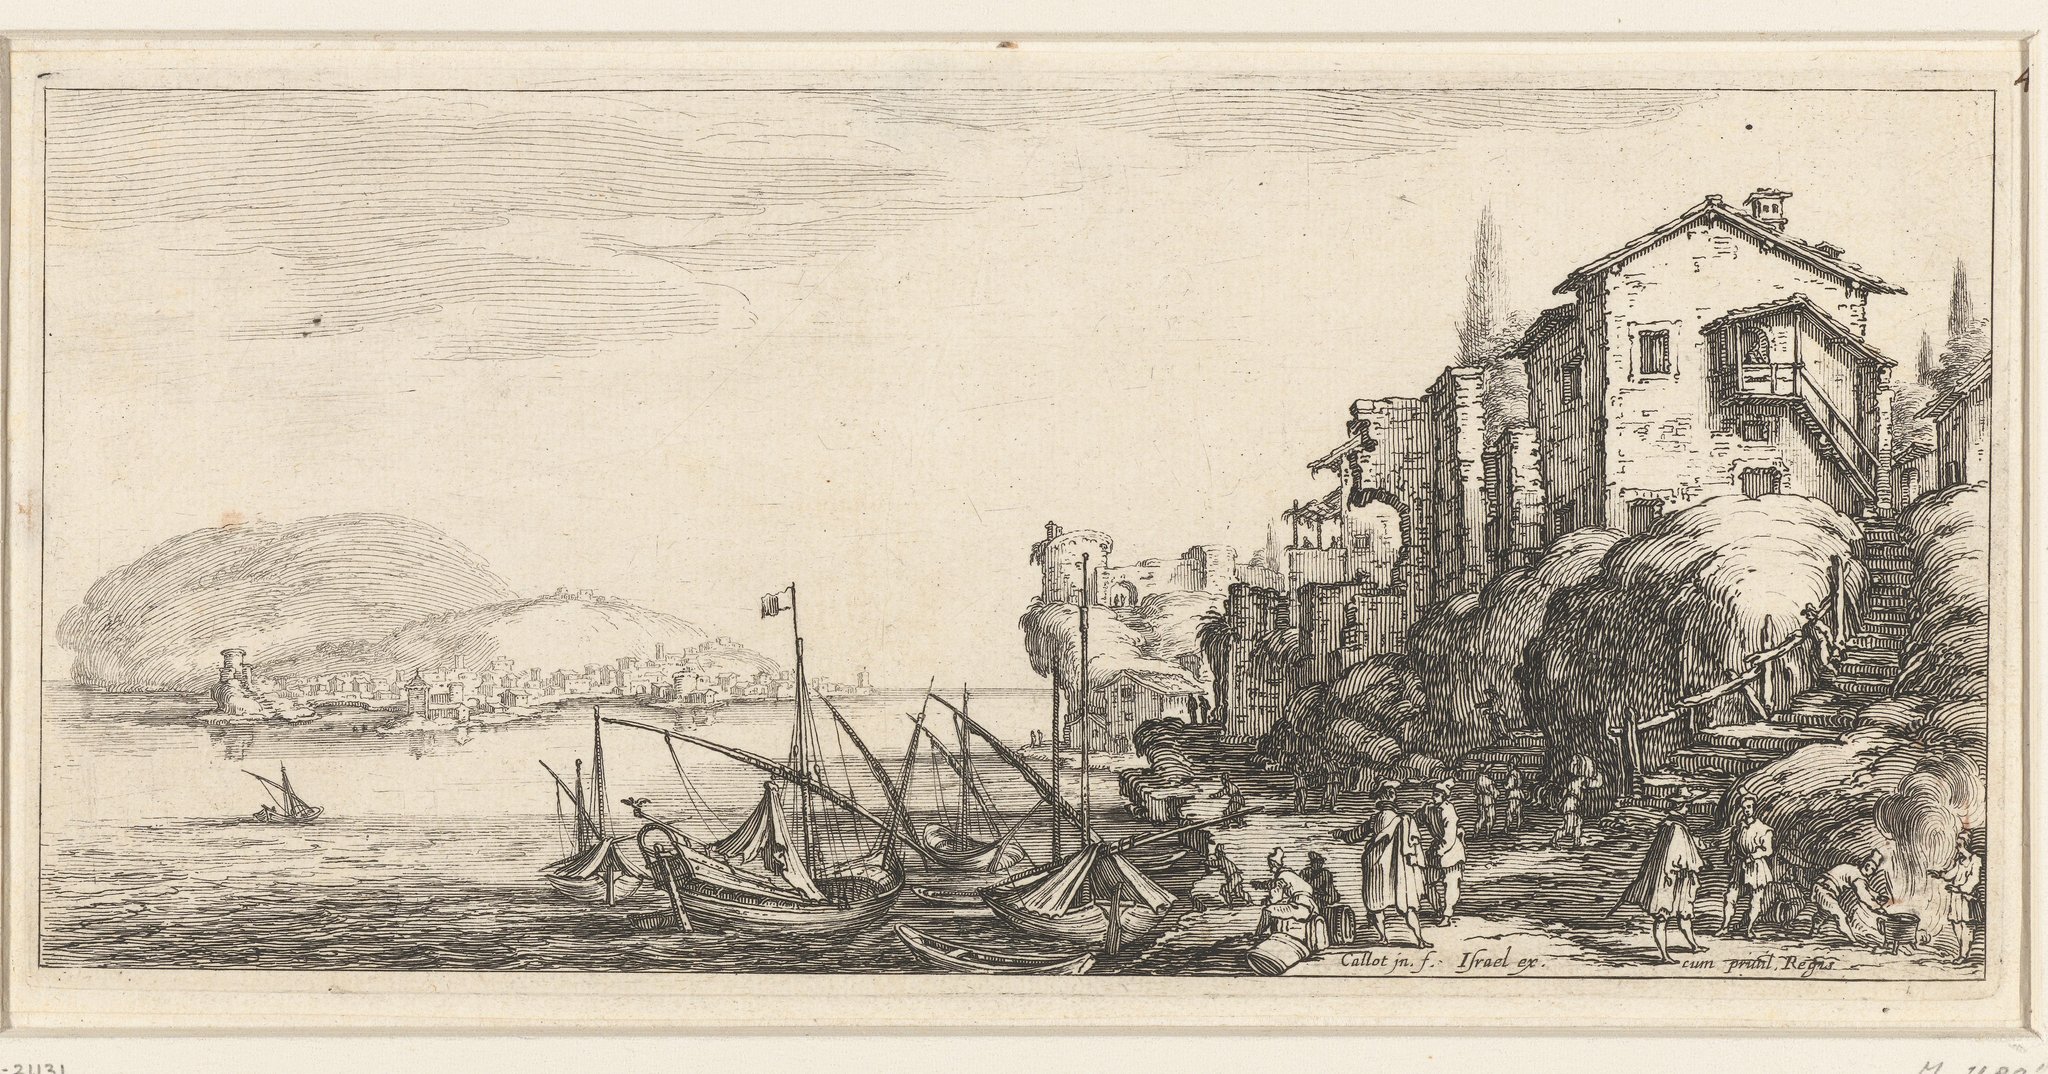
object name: print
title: Elf Italiaanse landschappen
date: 1628-1635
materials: paper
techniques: etching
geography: paris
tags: harbour, ships (in general), coast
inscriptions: collector's mark: Lugt 240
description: Enkele huizen aan de rand van een baai. Centraal op de voorgrond enkele scheepjes in het water nabij de kade. Deze prent is onderdeel van een serie van 11 Italiaanse (waarschijnlijk voornamelijk Florentijnse) landschappen (12 incl. titelprent).